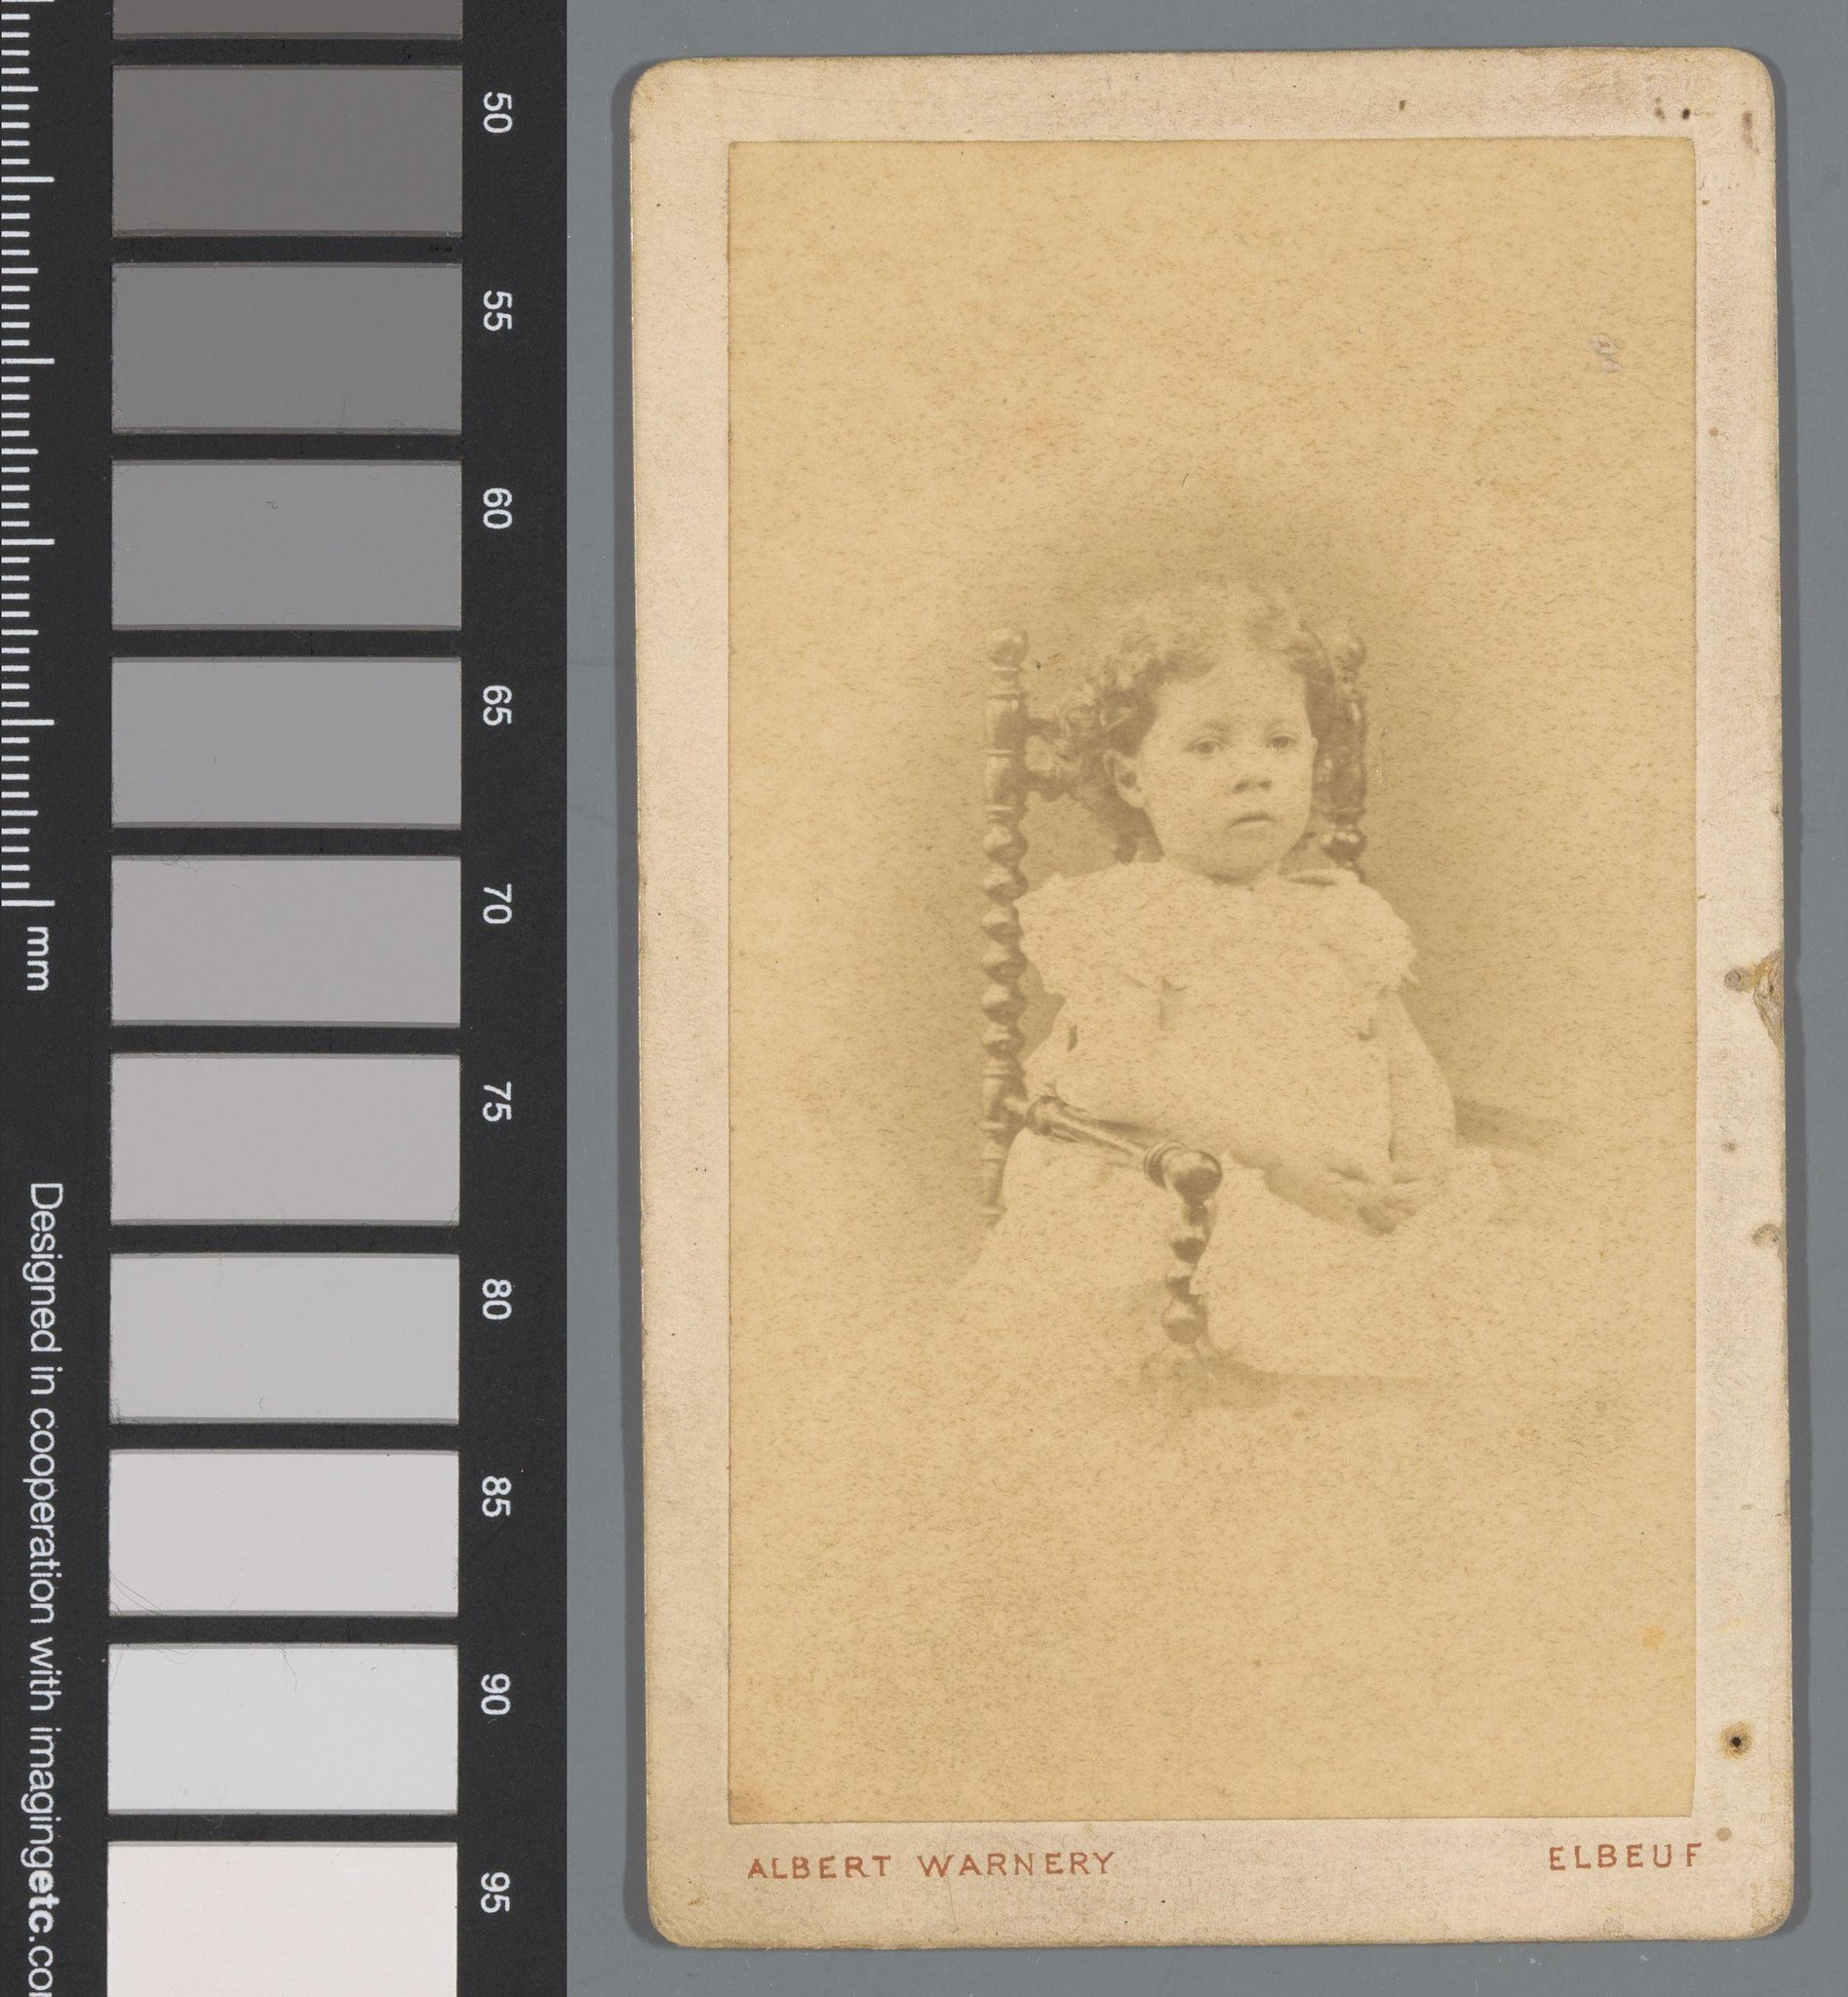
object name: carte de visite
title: Portret van een onbekend kind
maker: albert alfred warnery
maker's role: fotograaf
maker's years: 1853-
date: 1873-1885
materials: cardboard, paper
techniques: albumen print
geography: elbeuf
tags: anonymous historical person portrayed, toddler - aa - girl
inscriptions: address: ‘8, Rue St Auct, 8/ ELBEUF’, inscription: ‘Les Clichés sont conservés’